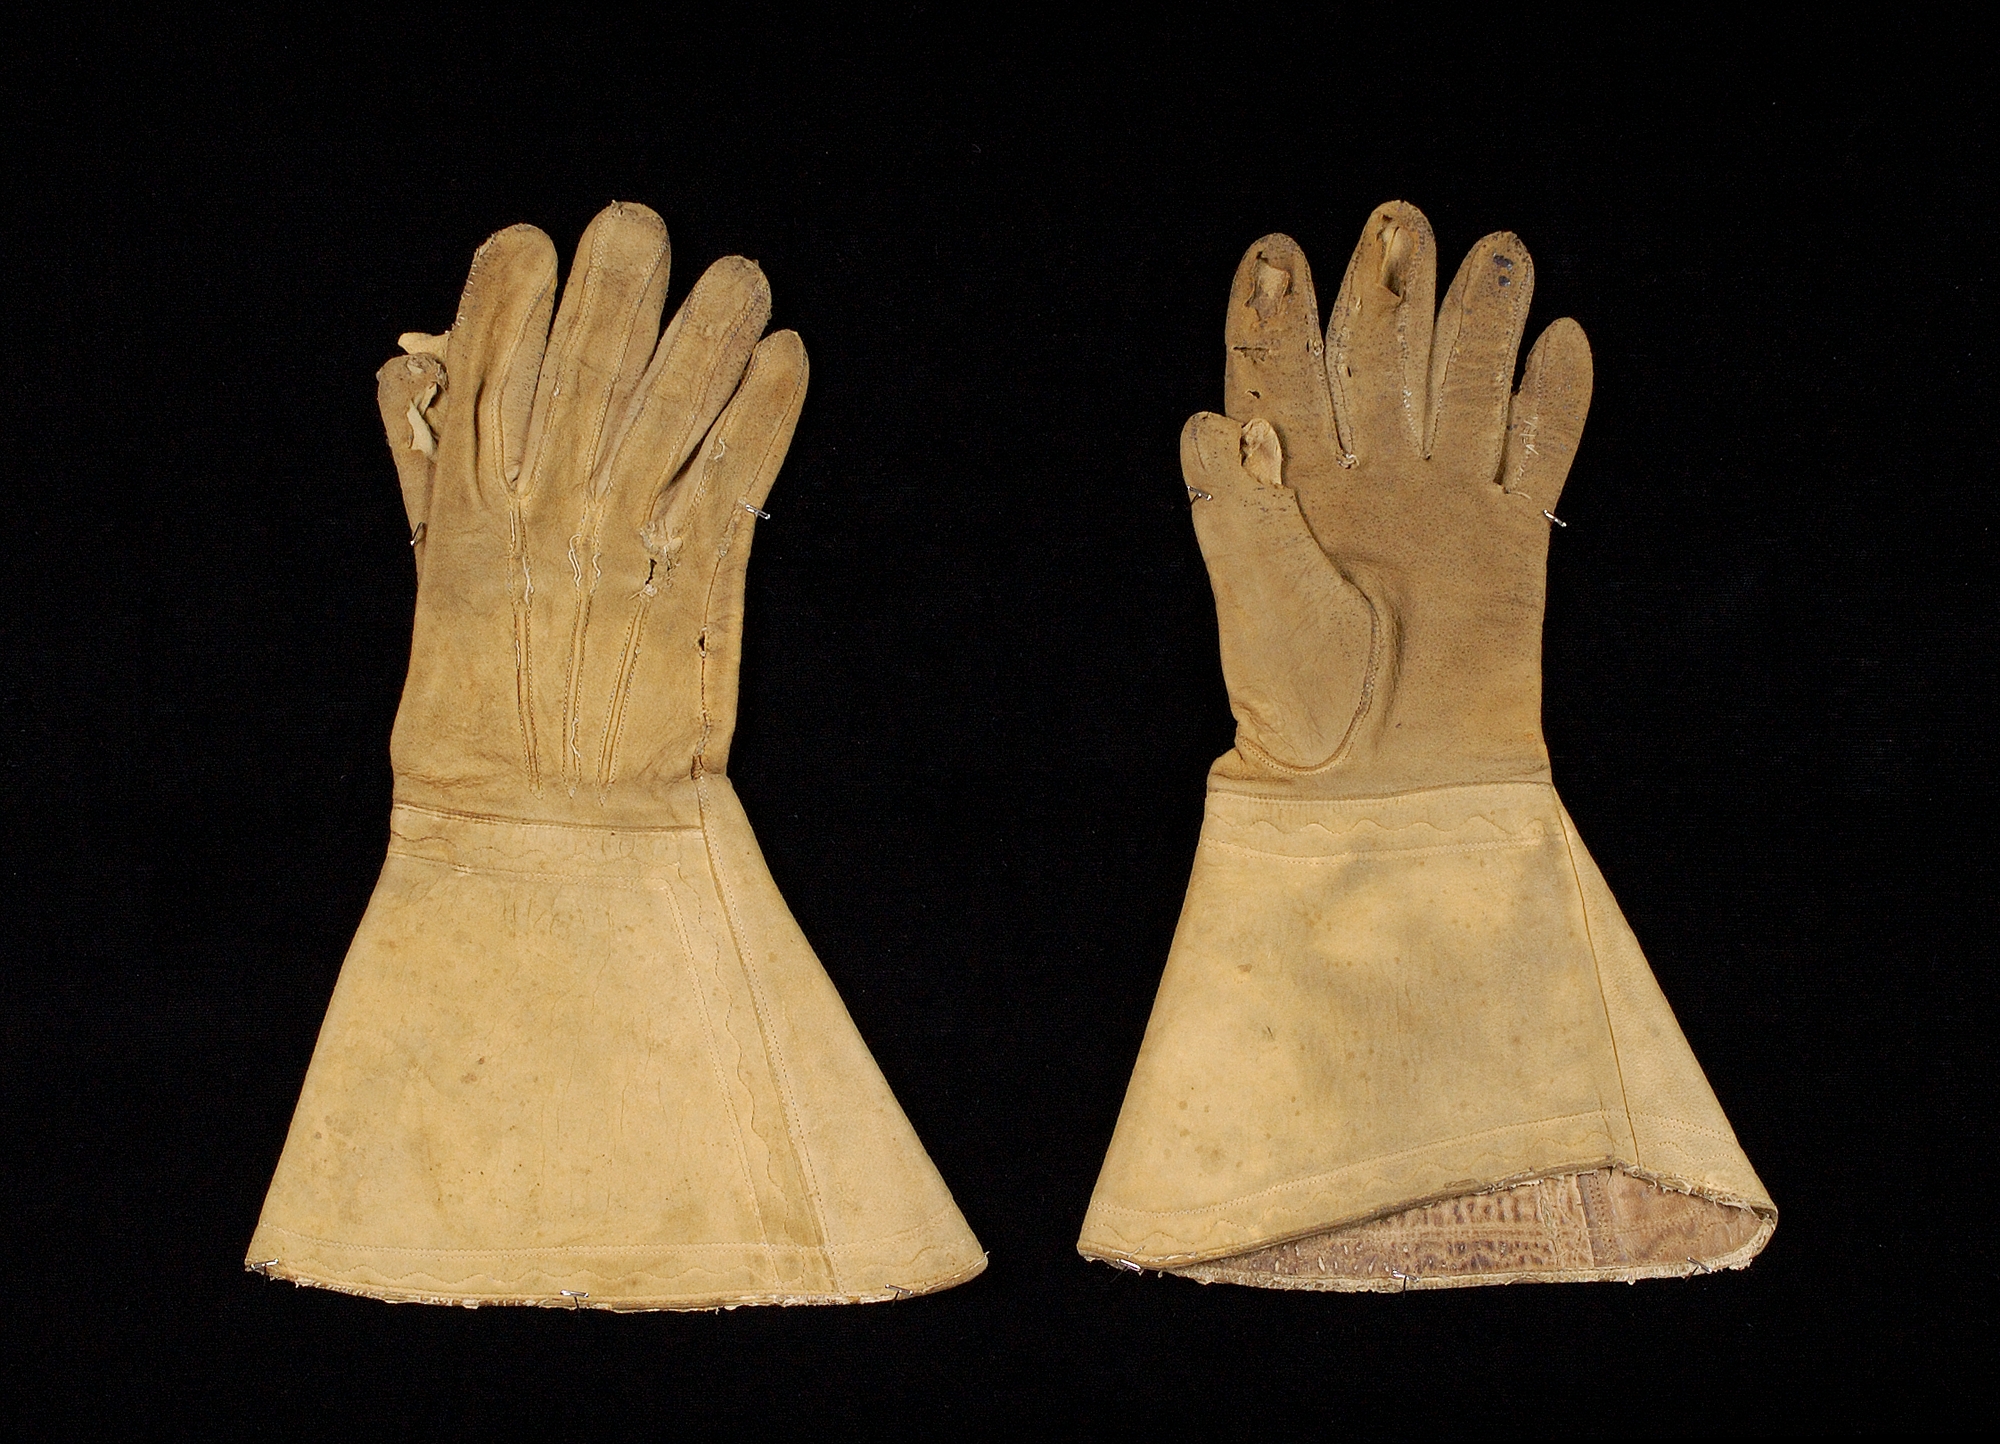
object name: glove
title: Gloves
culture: american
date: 1862-1864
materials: leather